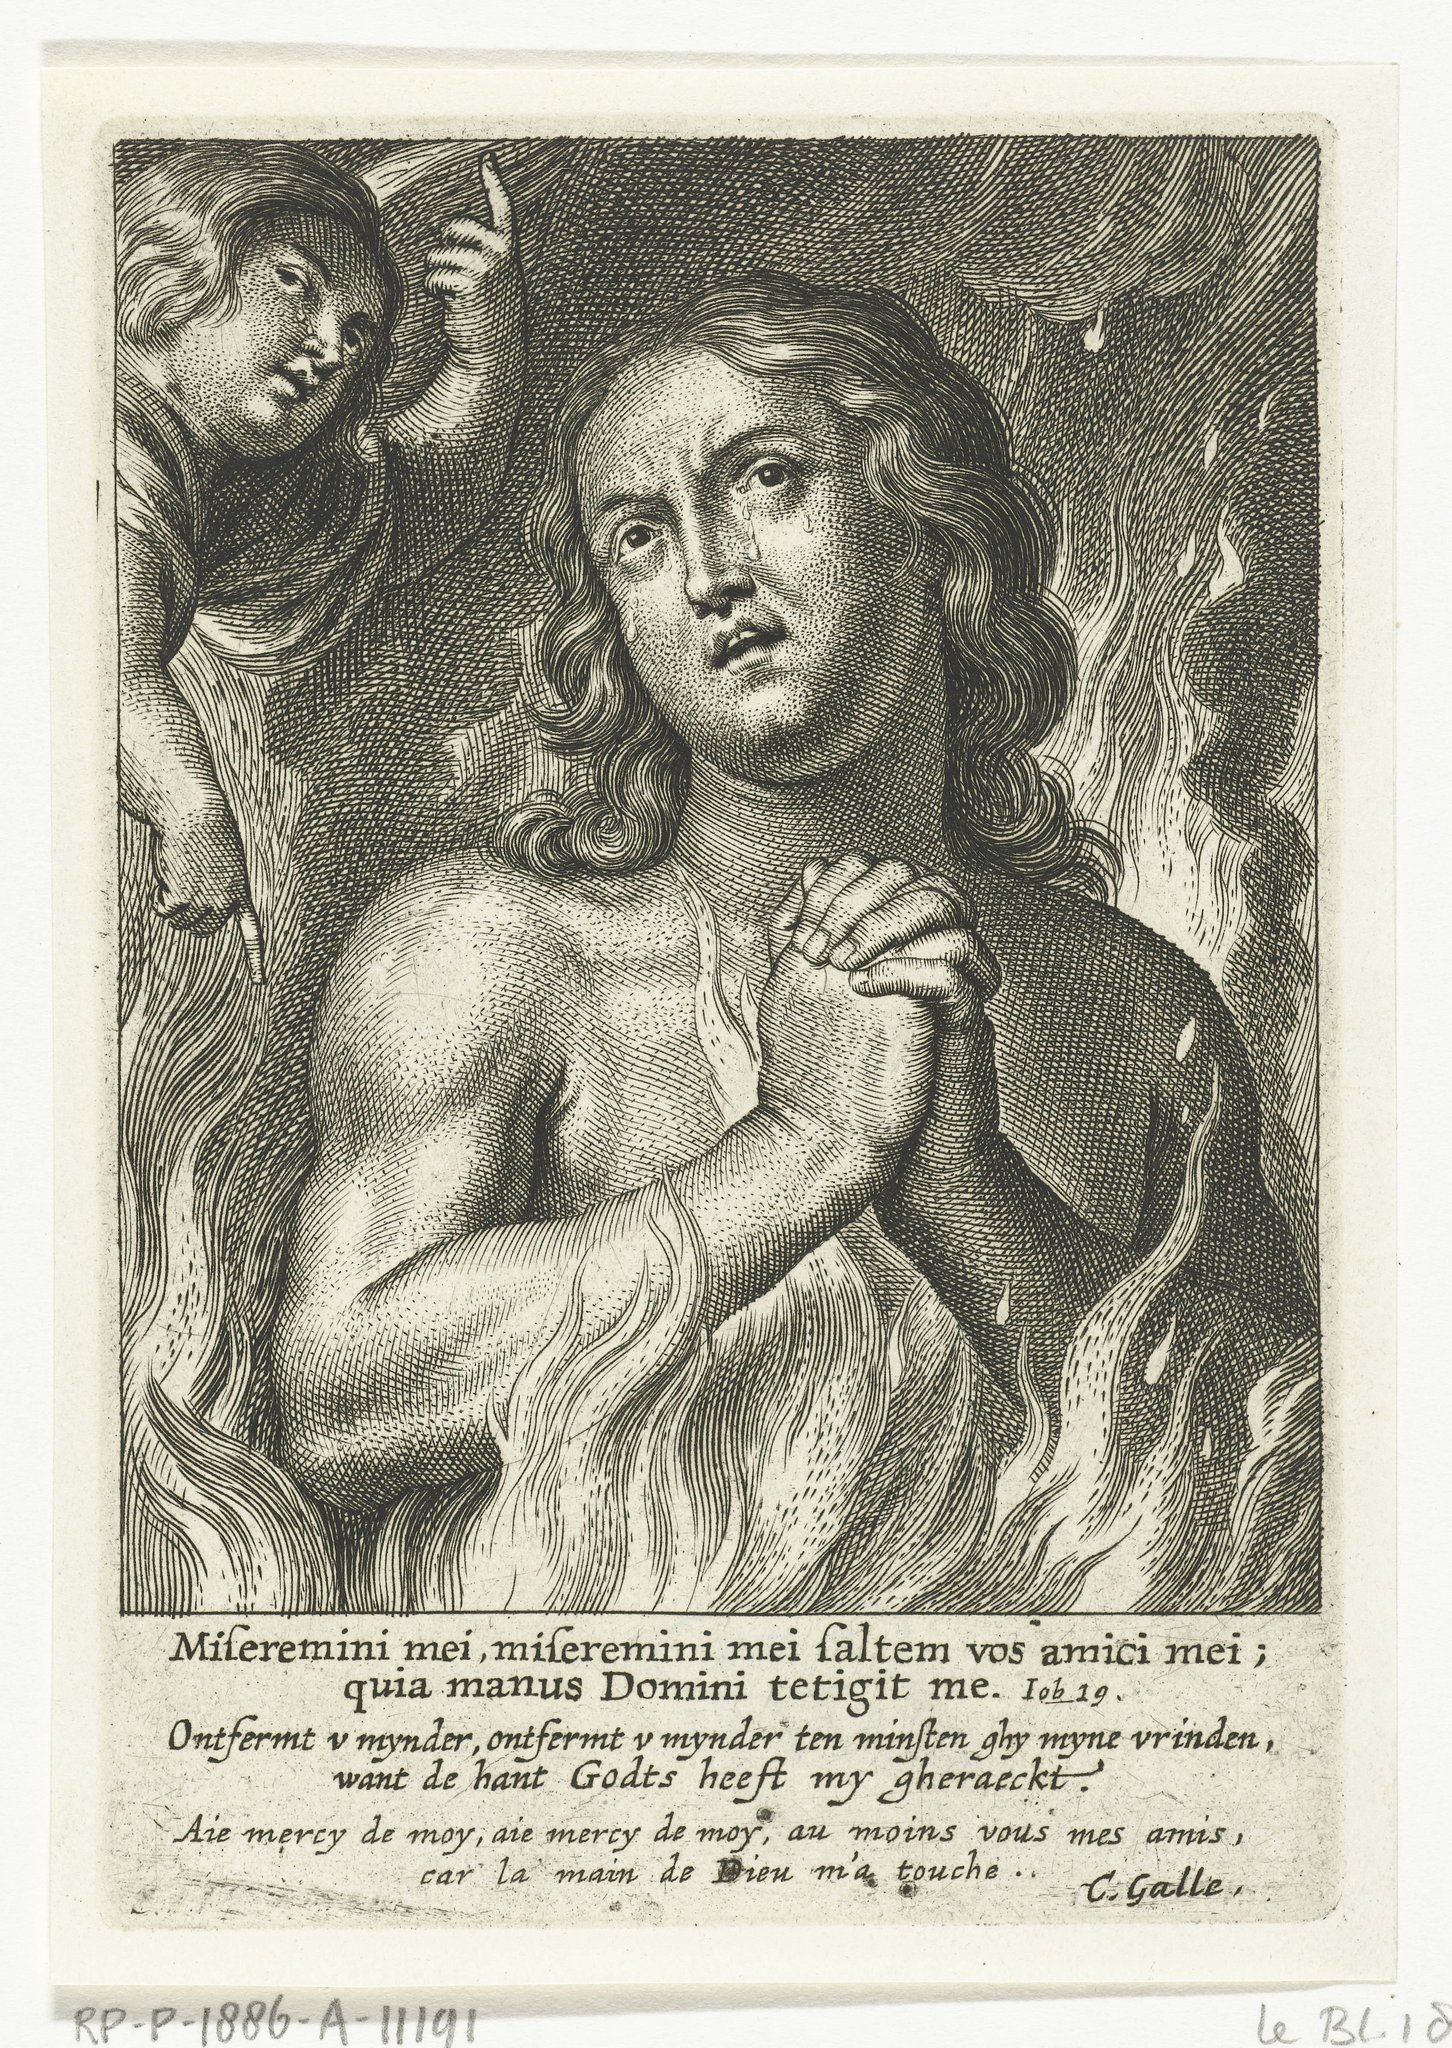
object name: print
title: Vélins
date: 1596-1678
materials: paper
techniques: engraving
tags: purgatory, usually the souls praying or asking for intercession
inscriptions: collector's mark: Lugt 2228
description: Prent uit serie Vélins met negentig prenten naar ontwerp van Peter Paul Rubens. In de bronnen vinden we uiteenlopende gegevens over aantal en samenstelling van de serie. Hollstein hanteert het aantal van negentig prenten. De reeks Vélins in de collectie van het RMA bevat verschillende staten afkomstig uit meerdere uitgaven welke moeilijk te duiden zijn. Sommige dragen het originele adres van Schelte Adamsz. Bolswert als graveur en uitgever, op andere exemplaren is deze naam verwijderd (duidelijk zichtbaar!) en vervangen door de naam Cornelis Galle (II). De prenten met de naam van uitgever Galle zijn vaak opgewerkt. We treffen nog een andere naam van een uitgever bij enkele prent aan: Martien van den Enden. Herkomst uit meerdere uitgaven spreekt ook uit afwijkende opschriften in Nederlands en Latijn en variaties op dezelfde thema's welke misschien nooit langs elkaar in dezelfde serie gebruikt werden.